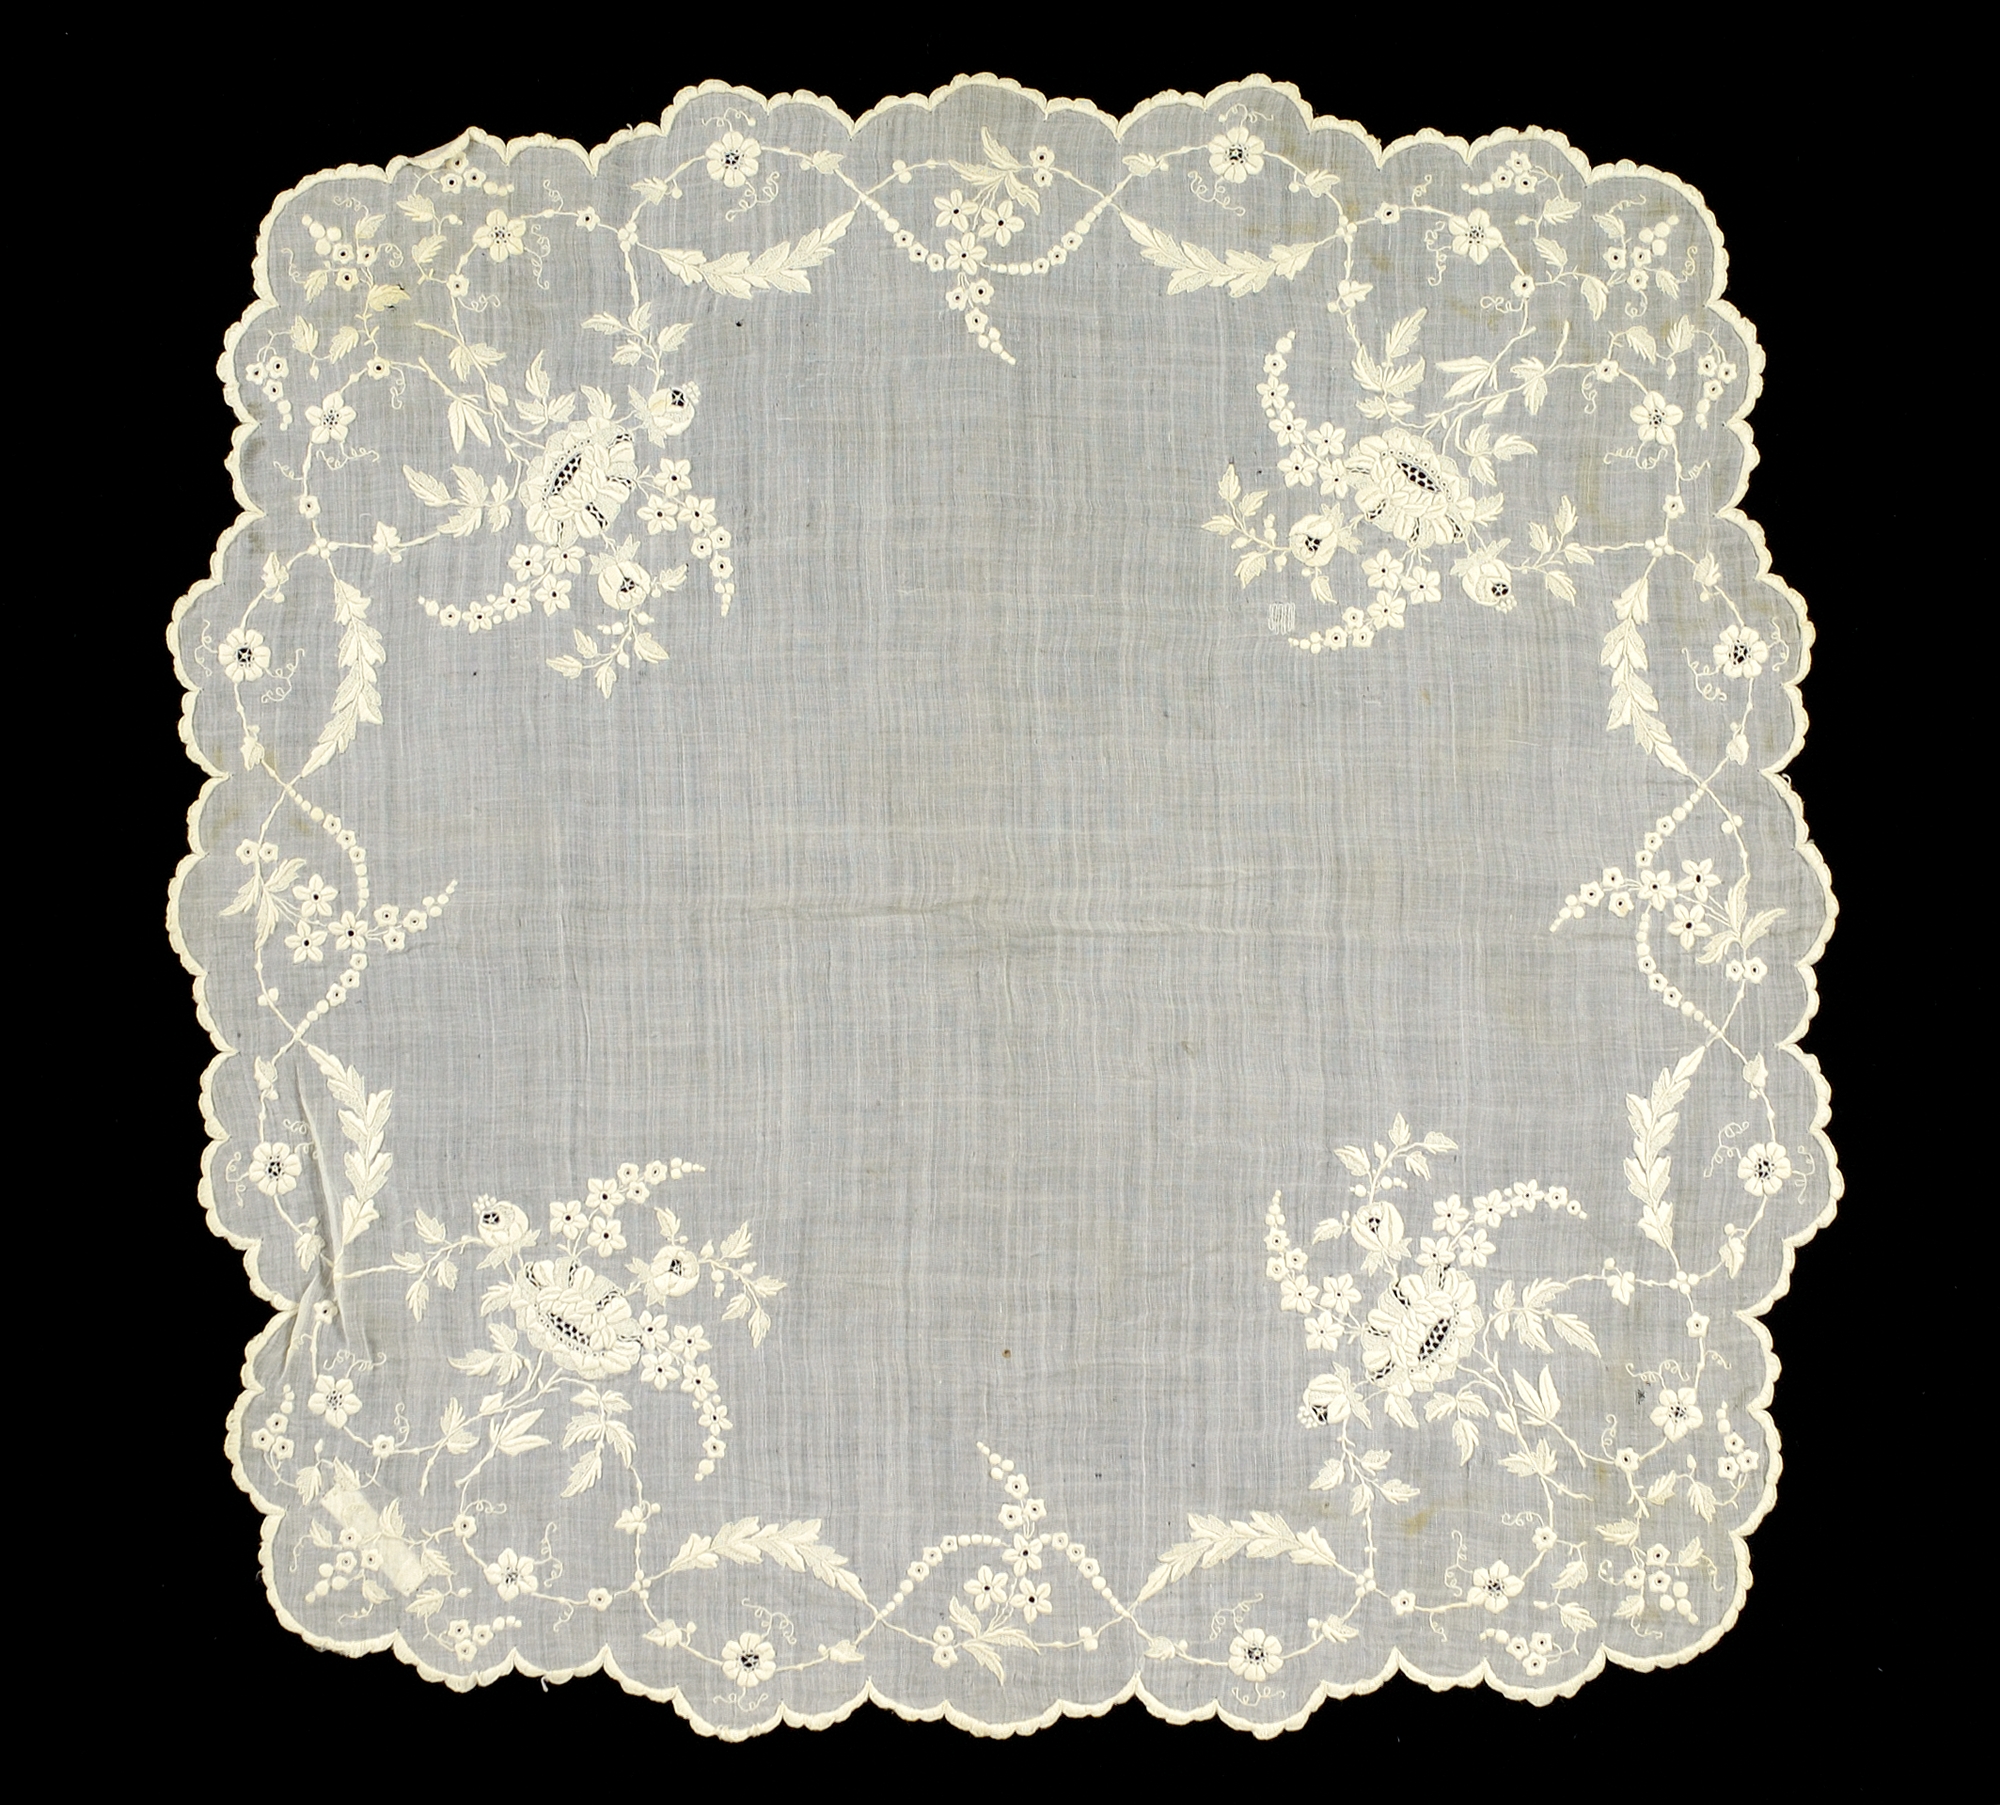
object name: handkerchief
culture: french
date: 1850-1870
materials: cotton